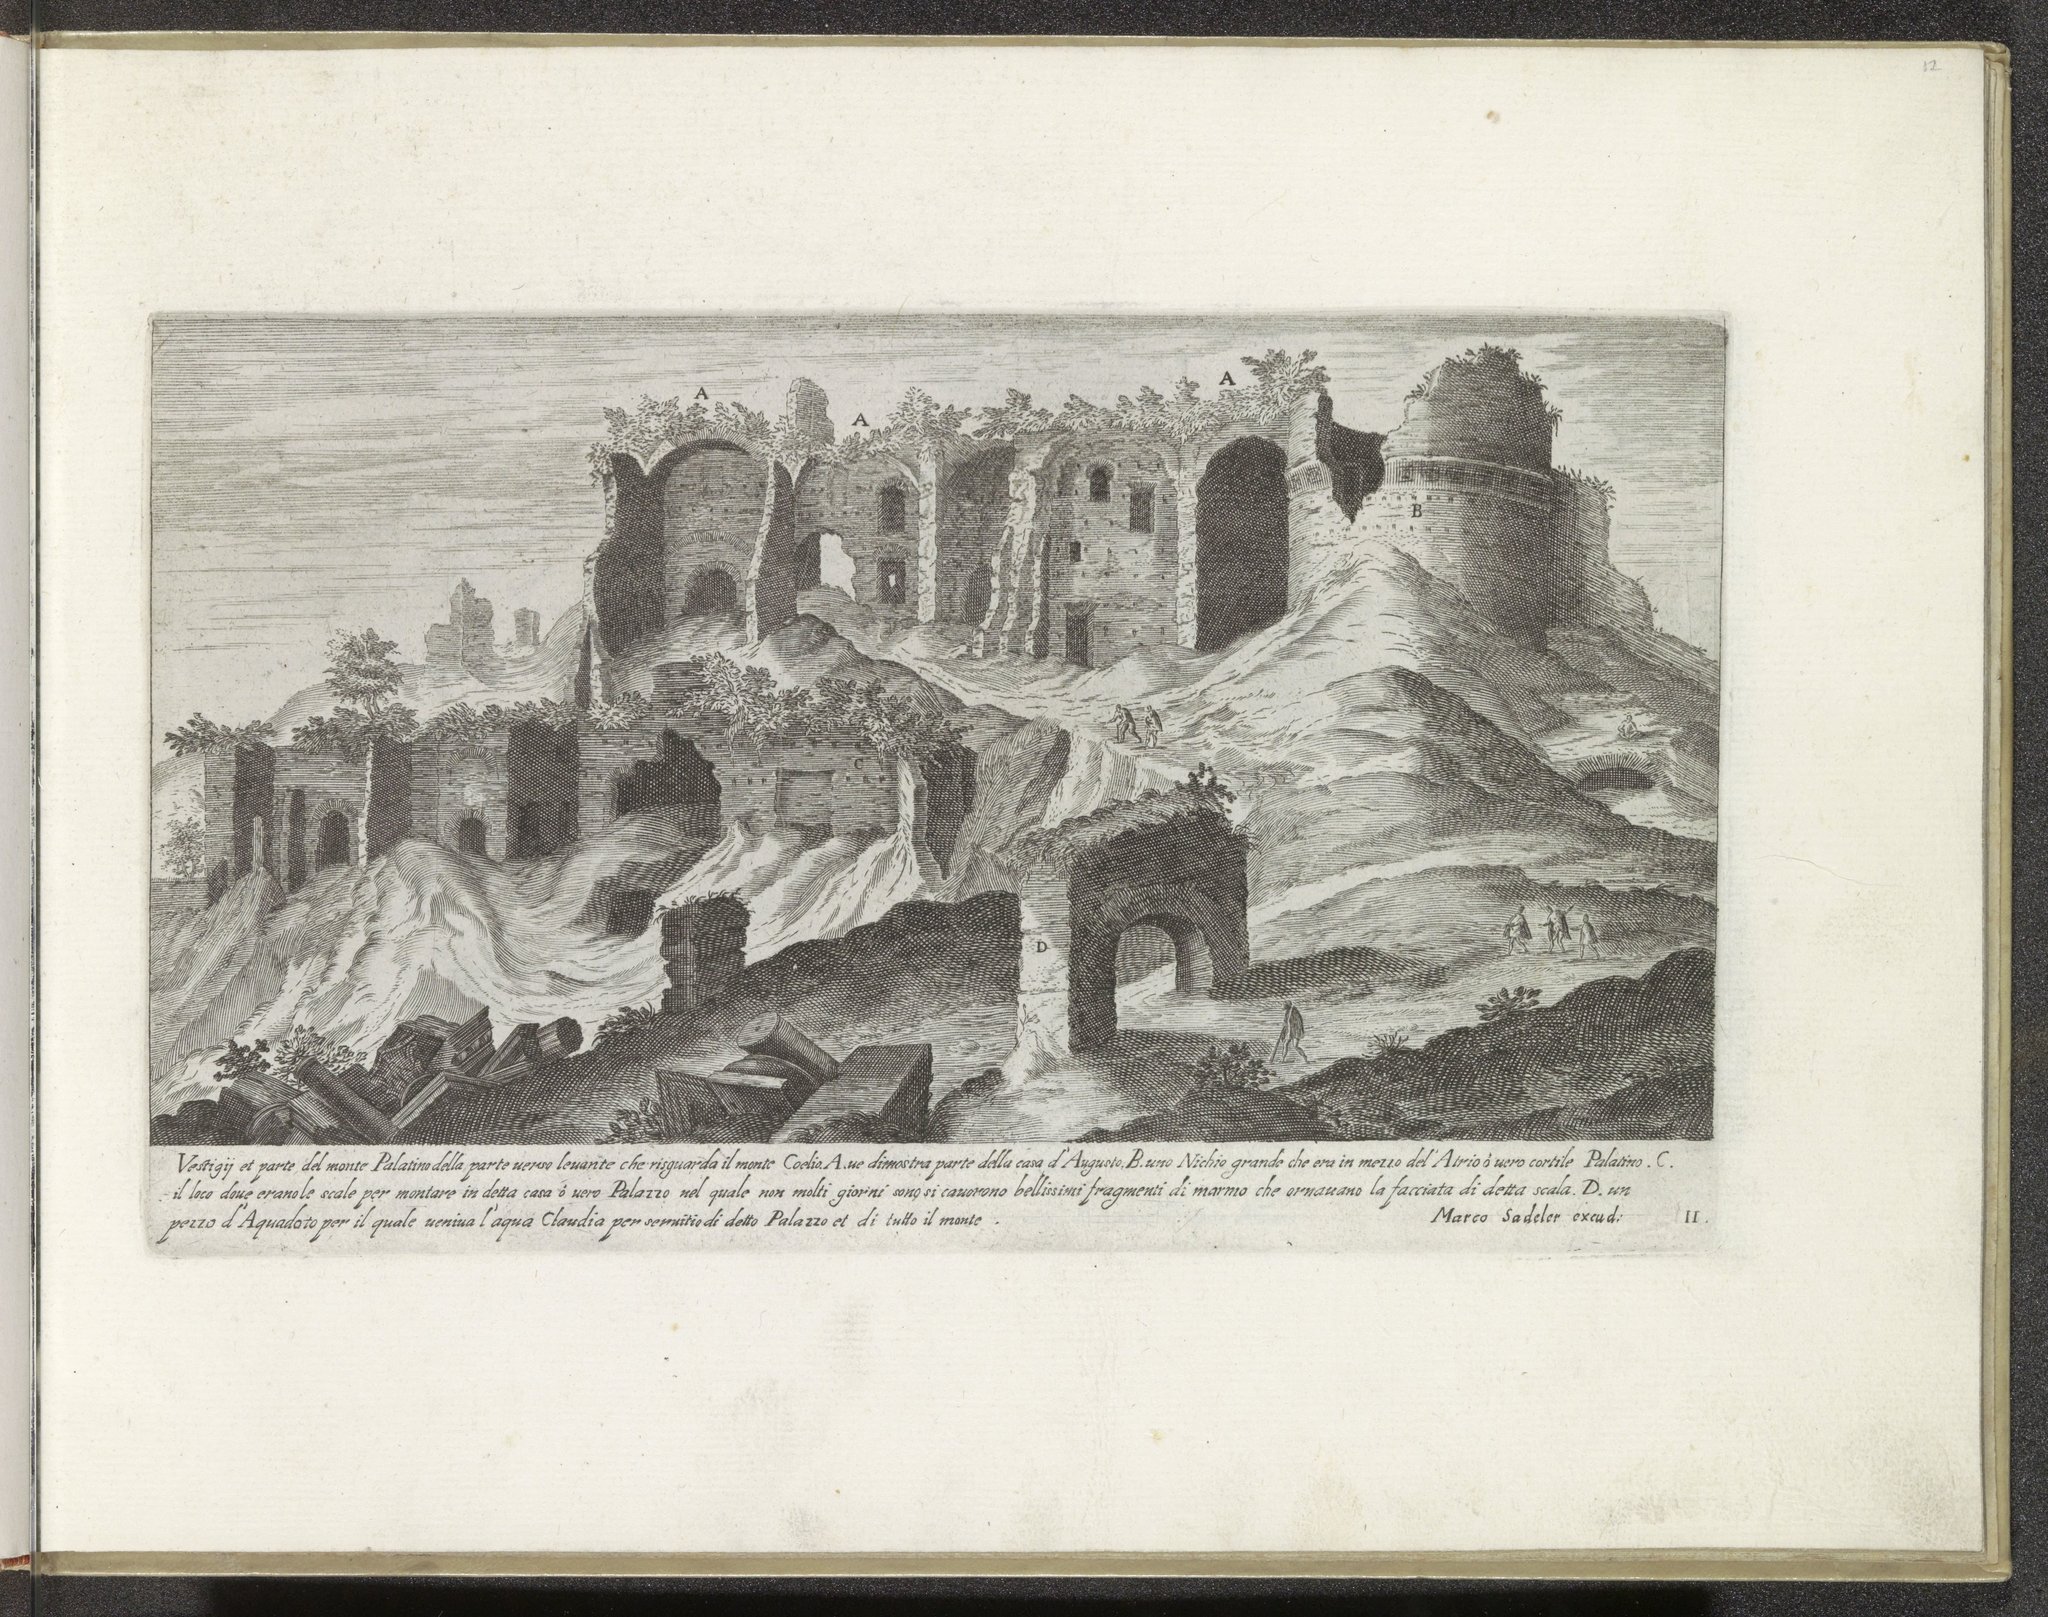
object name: album leaf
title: Ruïnes op de hellingen van de Palatijn, met een boog van de Aqua Claudia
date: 1606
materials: paper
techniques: engraving, etching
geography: prague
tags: casa di augusto, palatijn, aqua claudia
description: Ruïnes op de hellingen van de Palatijn, met de Casa di Augusto en een boog van de Aqua Claudia. In de ondermarge drie regels tekst in het Italiaans. De prent maakt deel uit van een album.